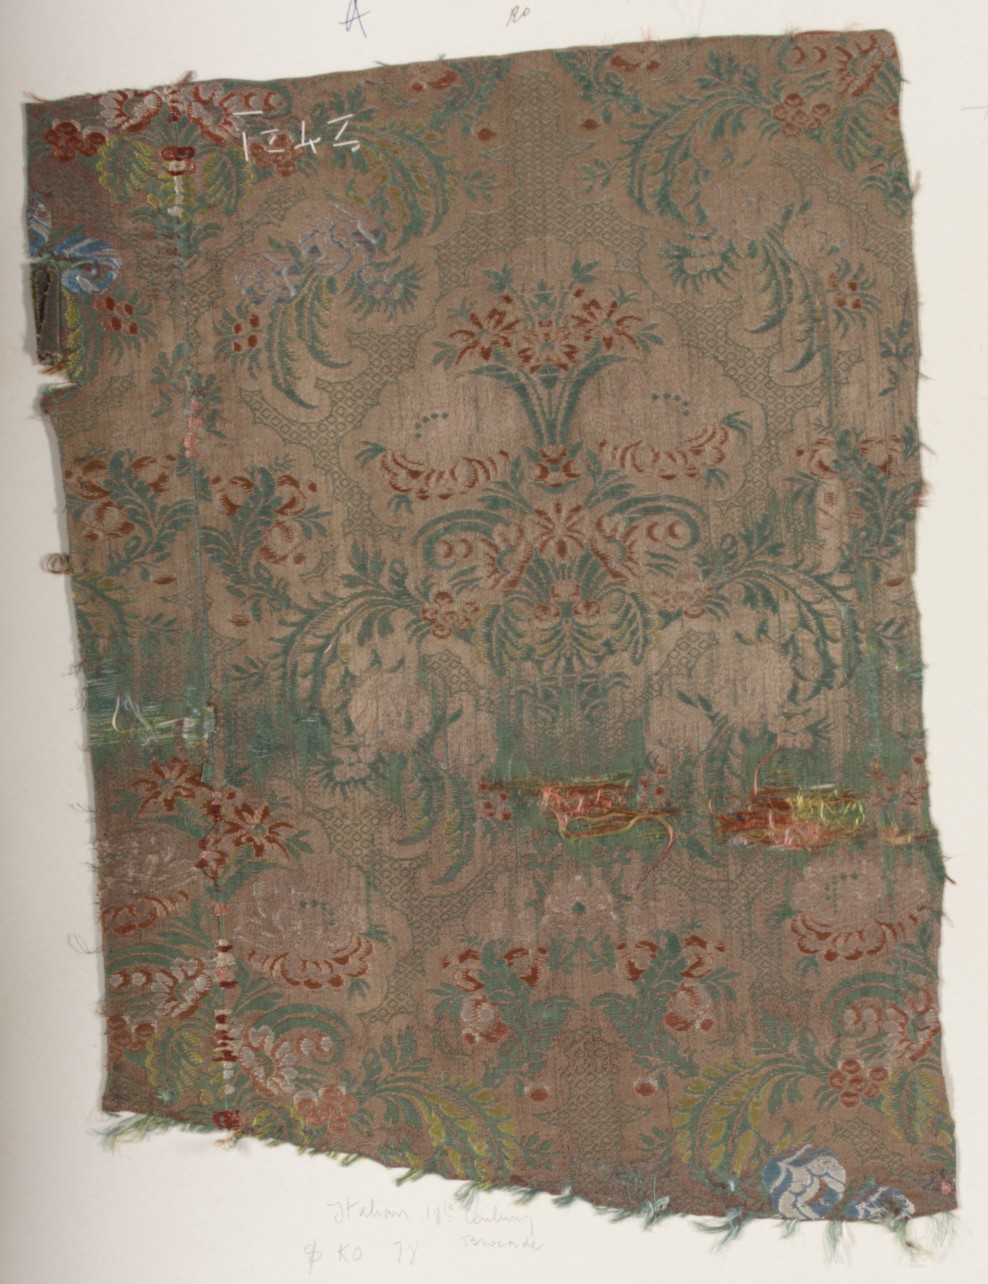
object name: fragment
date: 1701-1800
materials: silk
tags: flowers,leaves